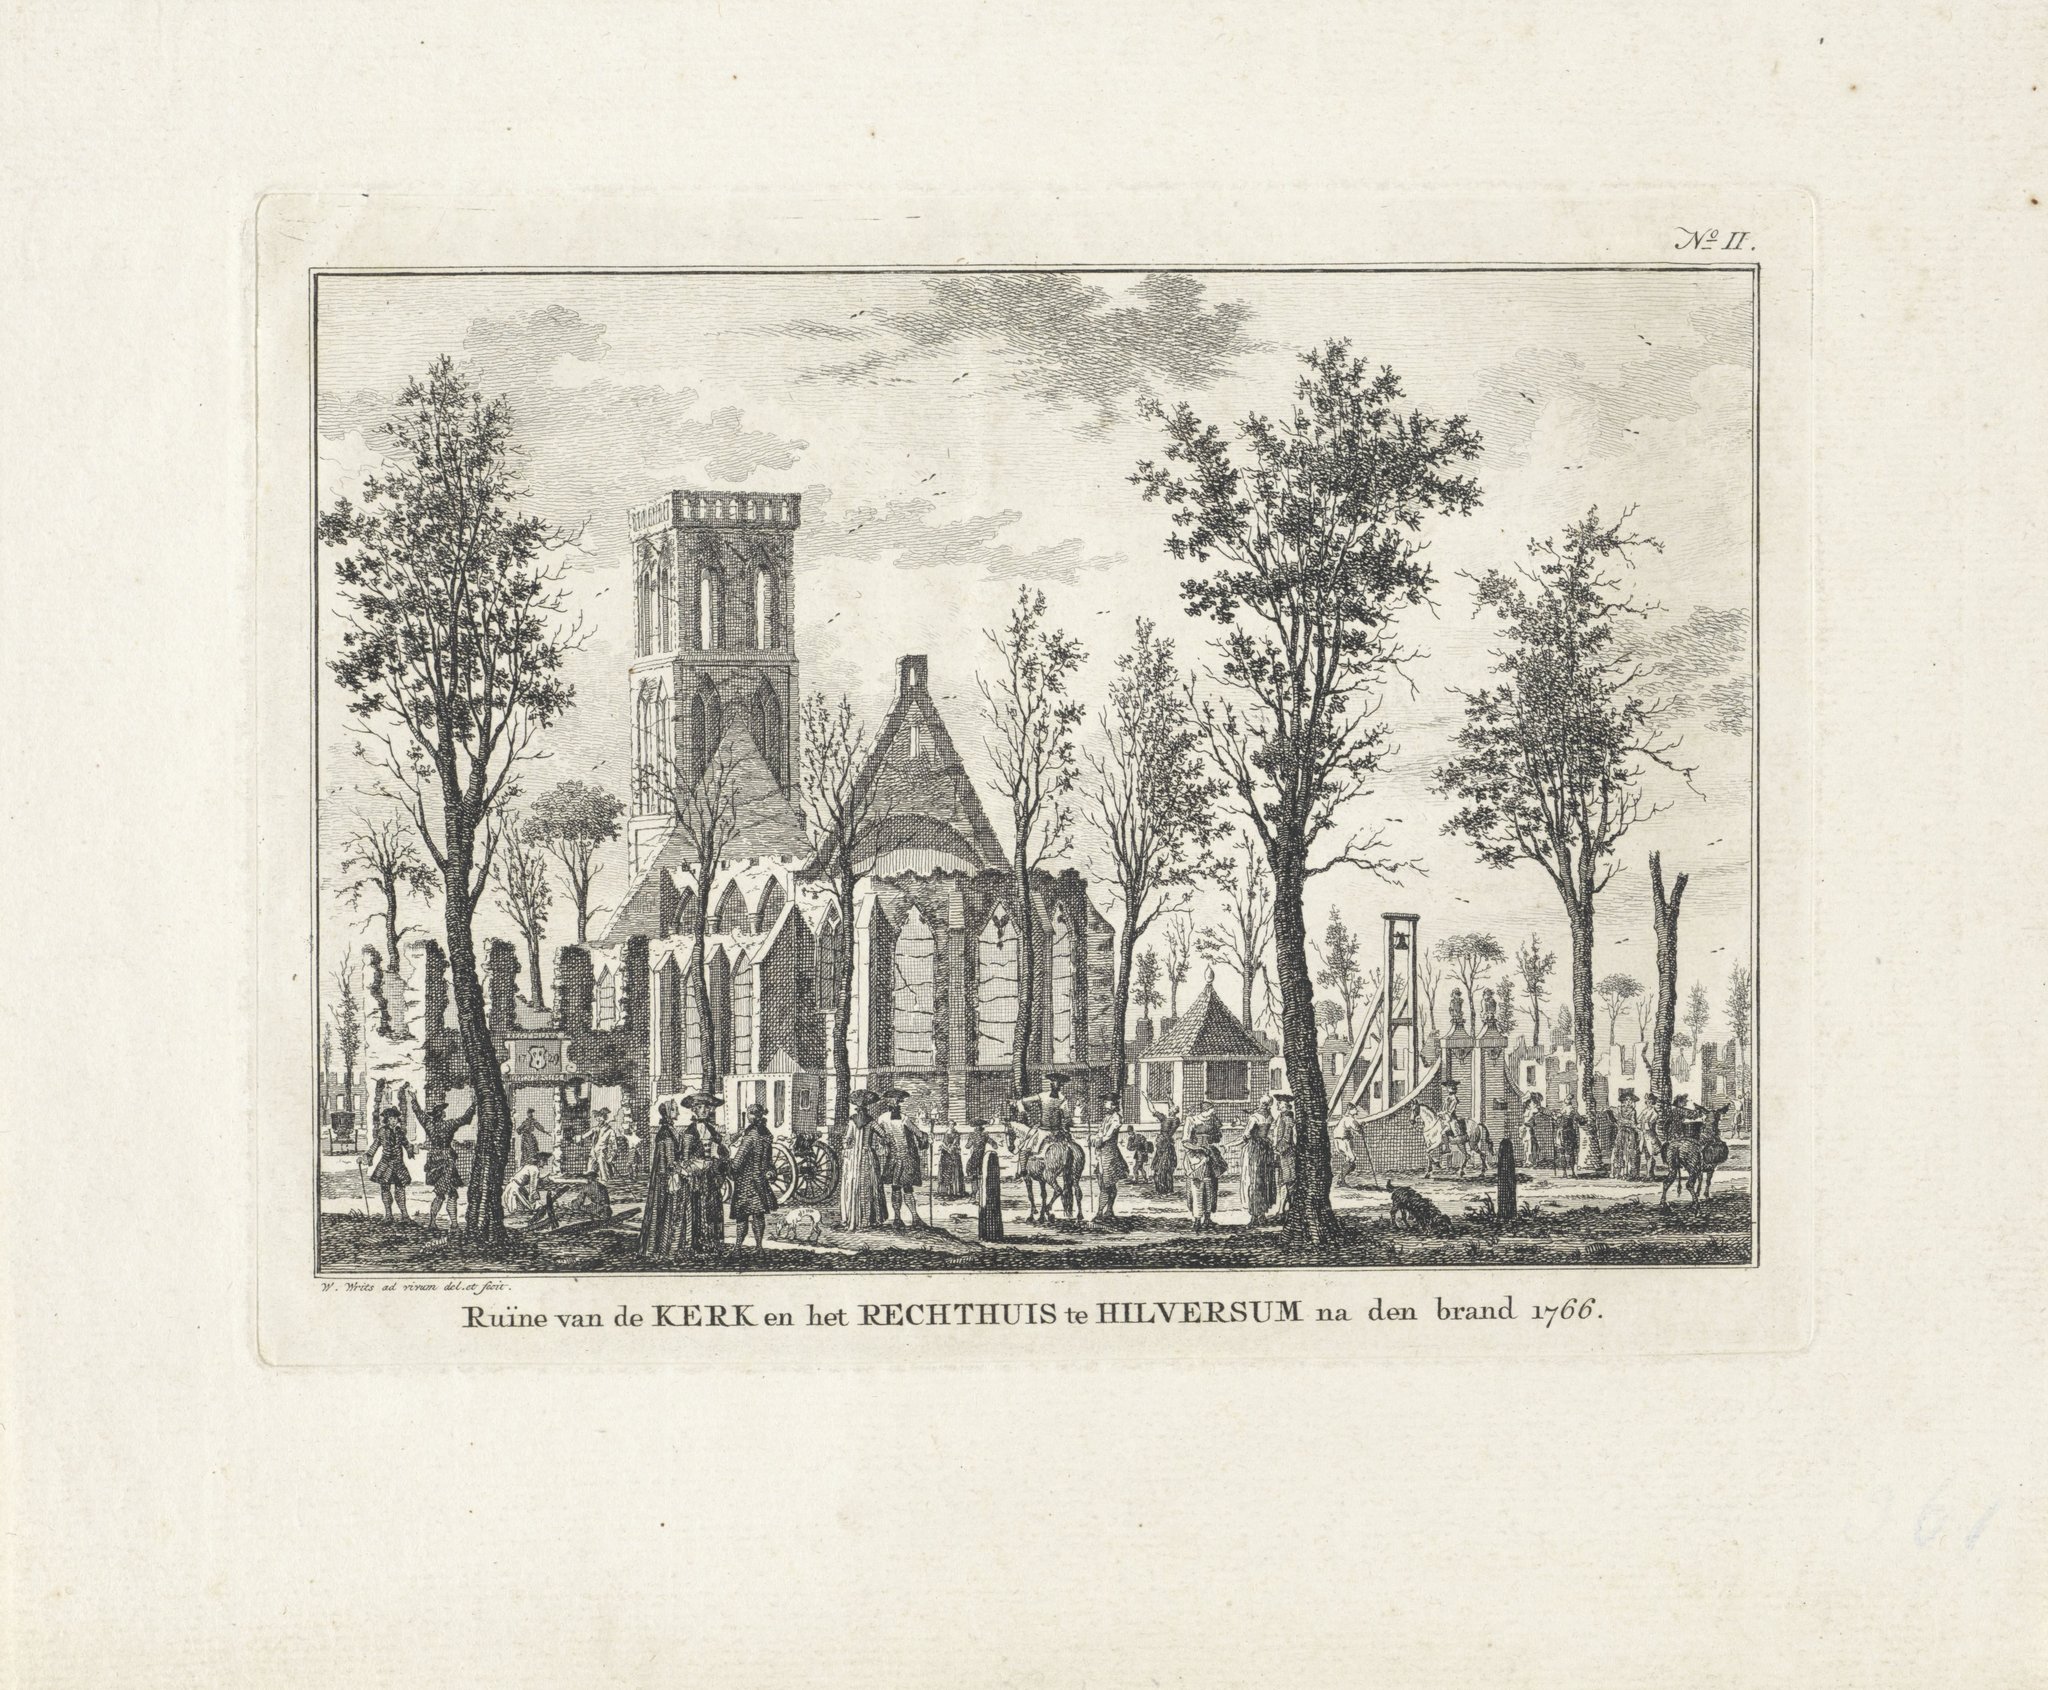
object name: print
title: Ruïne van de Kerk en het Rechthuis te Hilversum na den brand 1766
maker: willem writs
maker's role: draughtsman, print maker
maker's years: 1731-1786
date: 1766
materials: paper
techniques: etching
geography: amsterdam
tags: ruin of church, monastery, etc.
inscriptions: collector's mark: Lugt 2228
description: Gezicht op de ruïne van de Kerk en het Rechthuis te Hilversum na de brand van 25 juni 1766. Bij deze plaat behoort een prent van de kerk vóór de brand van 1766.